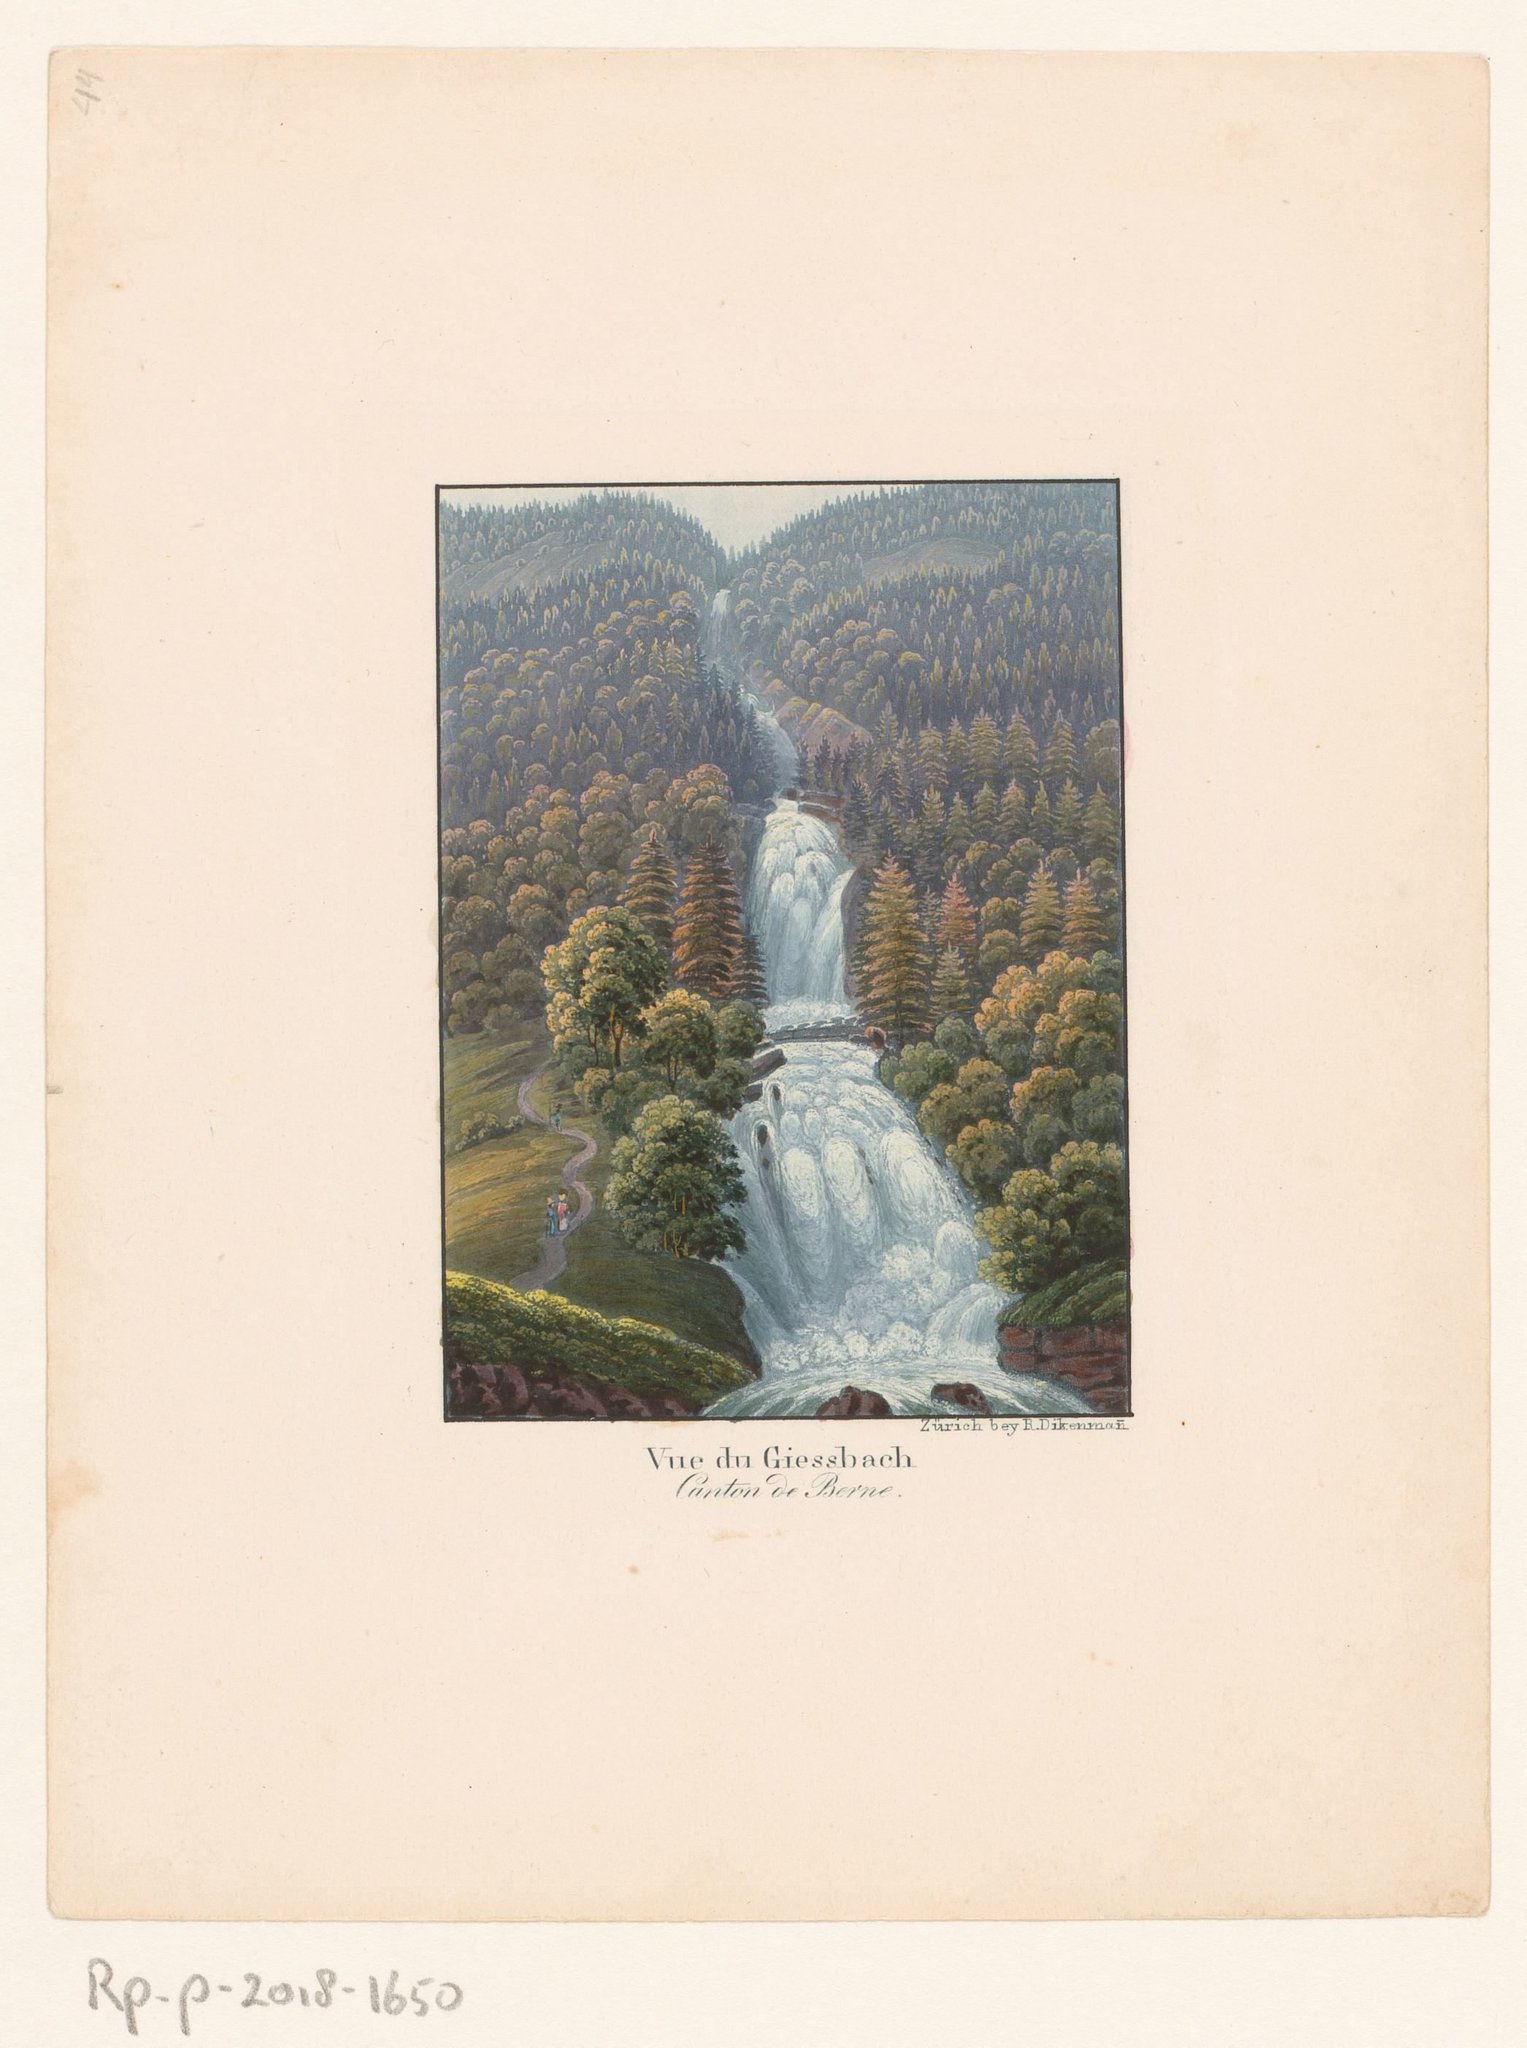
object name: print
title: Vue du Giessbach Canton de Berne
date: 1800-1899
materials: paper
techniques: aquatint, hand coloring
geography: zurich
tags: waterfall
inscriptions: collector's mark: Lugt 2228